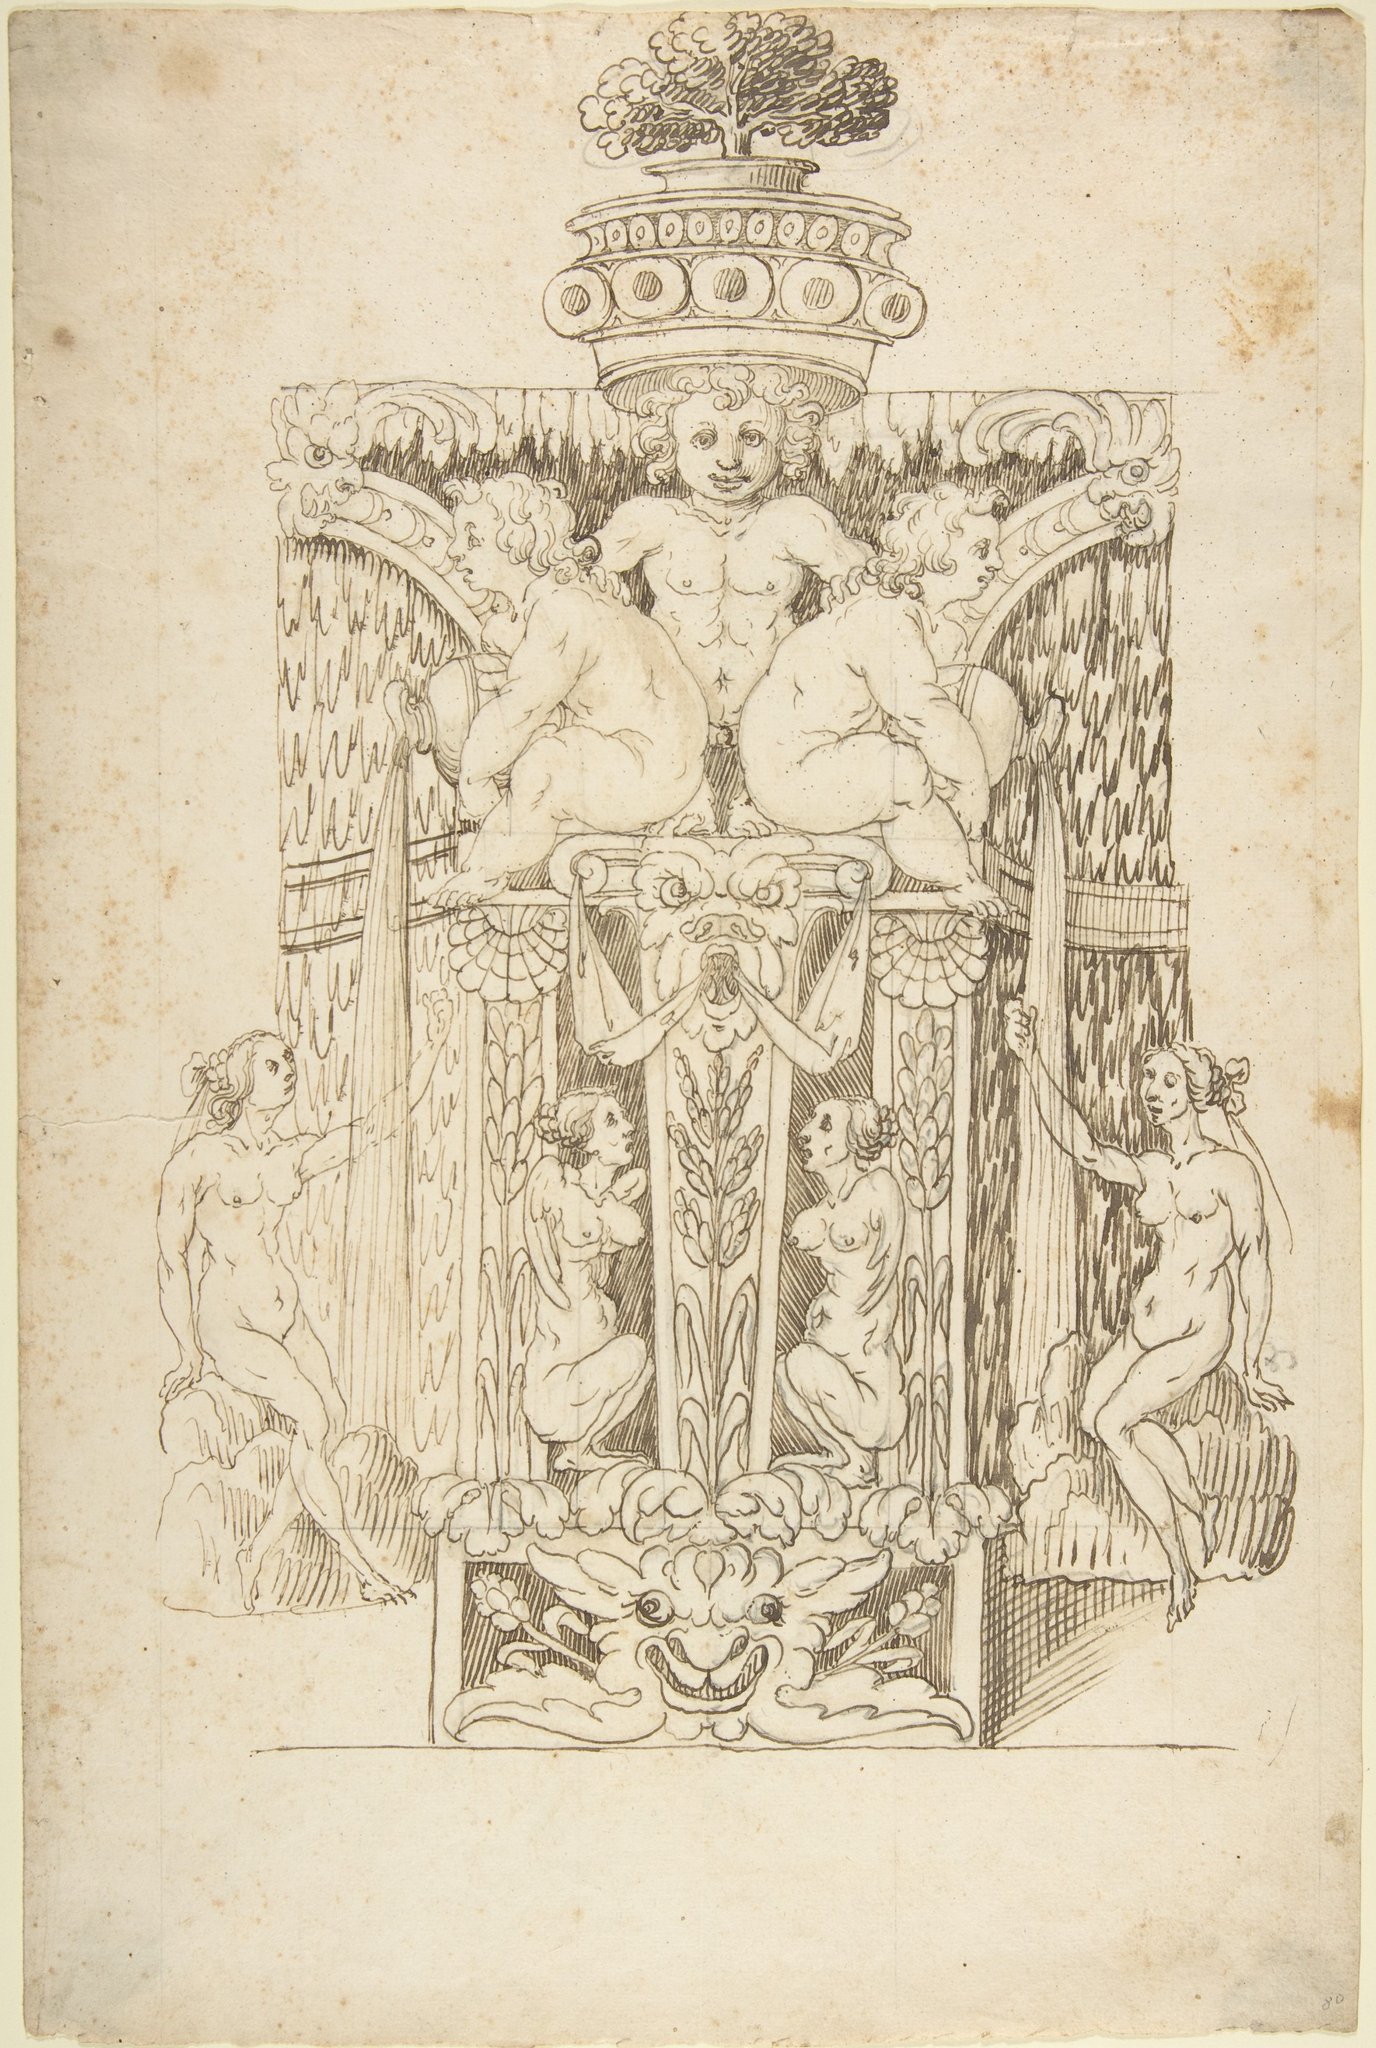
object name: drawing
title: Design for a Wall Fountain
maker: anonymous, italian, lombard, 16th century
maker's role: artist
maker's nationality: italian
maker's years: 1500-1600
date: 1550-1620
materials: ink, drawing material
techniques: brush, pen, wash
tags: female nudes,plants